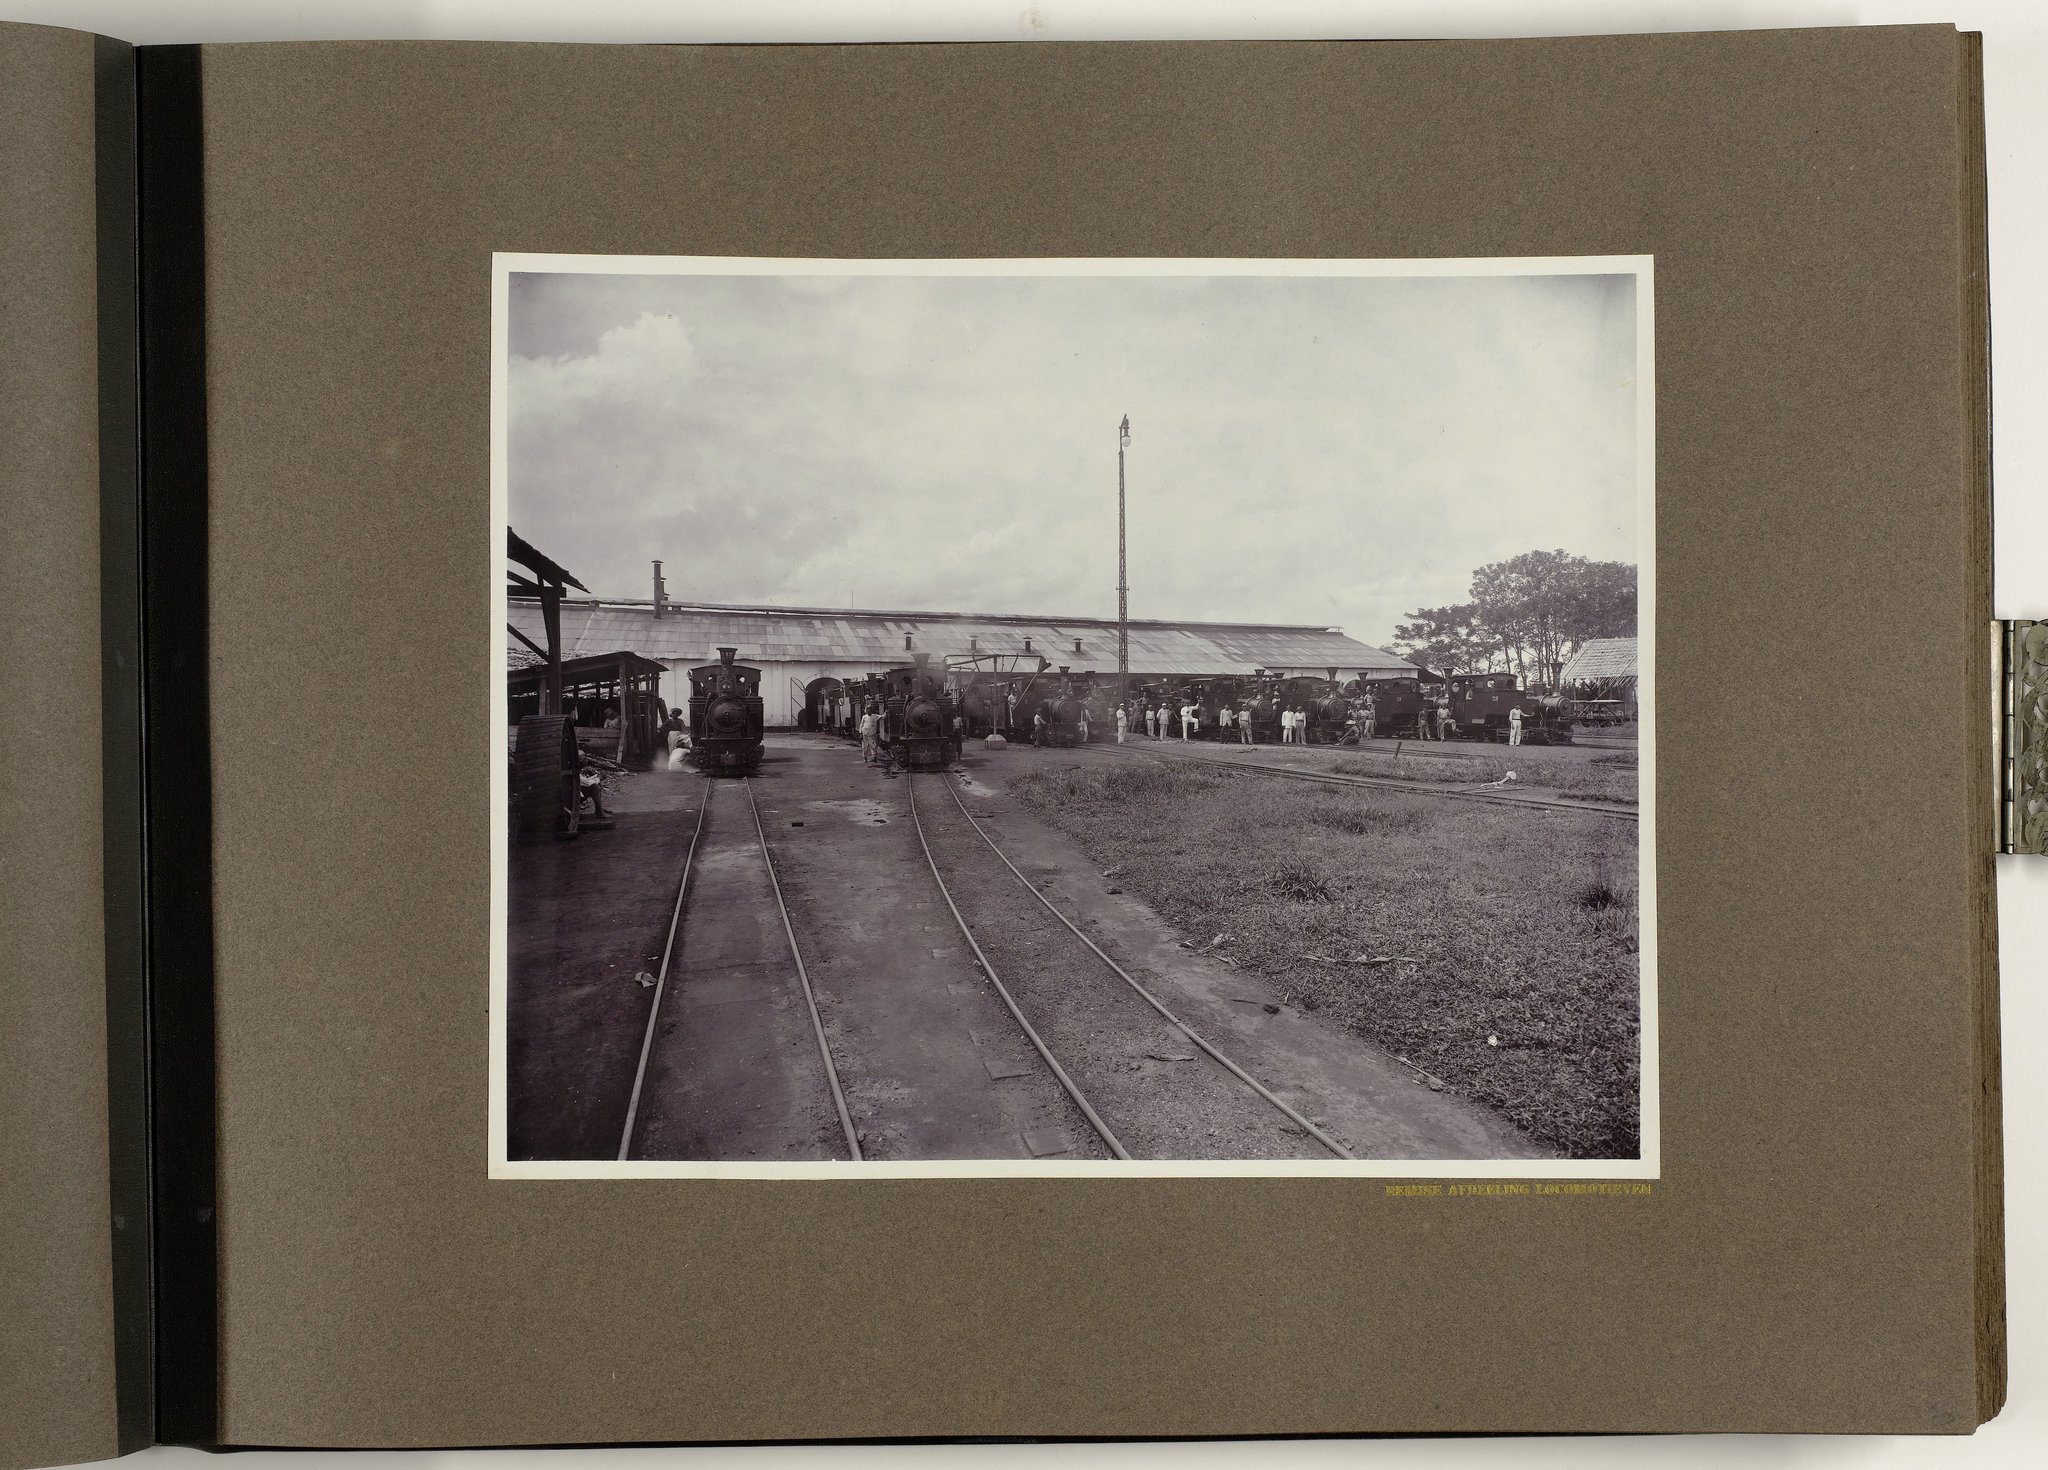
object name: photograph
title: Remise afdeeling locomotieven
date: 1917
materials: photographic support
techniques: gelatin silver print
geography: jatiroto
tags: colonial system, locomotive, (non-fruit) products of plants or trees: sugarcane, station; shelter (railway, tramway)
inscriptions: inscription: ‘REMISE AFDEELING LOCOMOTIEVEN’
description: De remise van de Afdeling Locomotieven met negen locomotieven op een rangeerterrein bij de suikerfabriek. Naast de locomotieven poseren werknemers. Onderdeel van het fotoalbum aangeboden aan F.J. Wirix door het personeel van de Suikeronderneming Djatiroto in 1917.